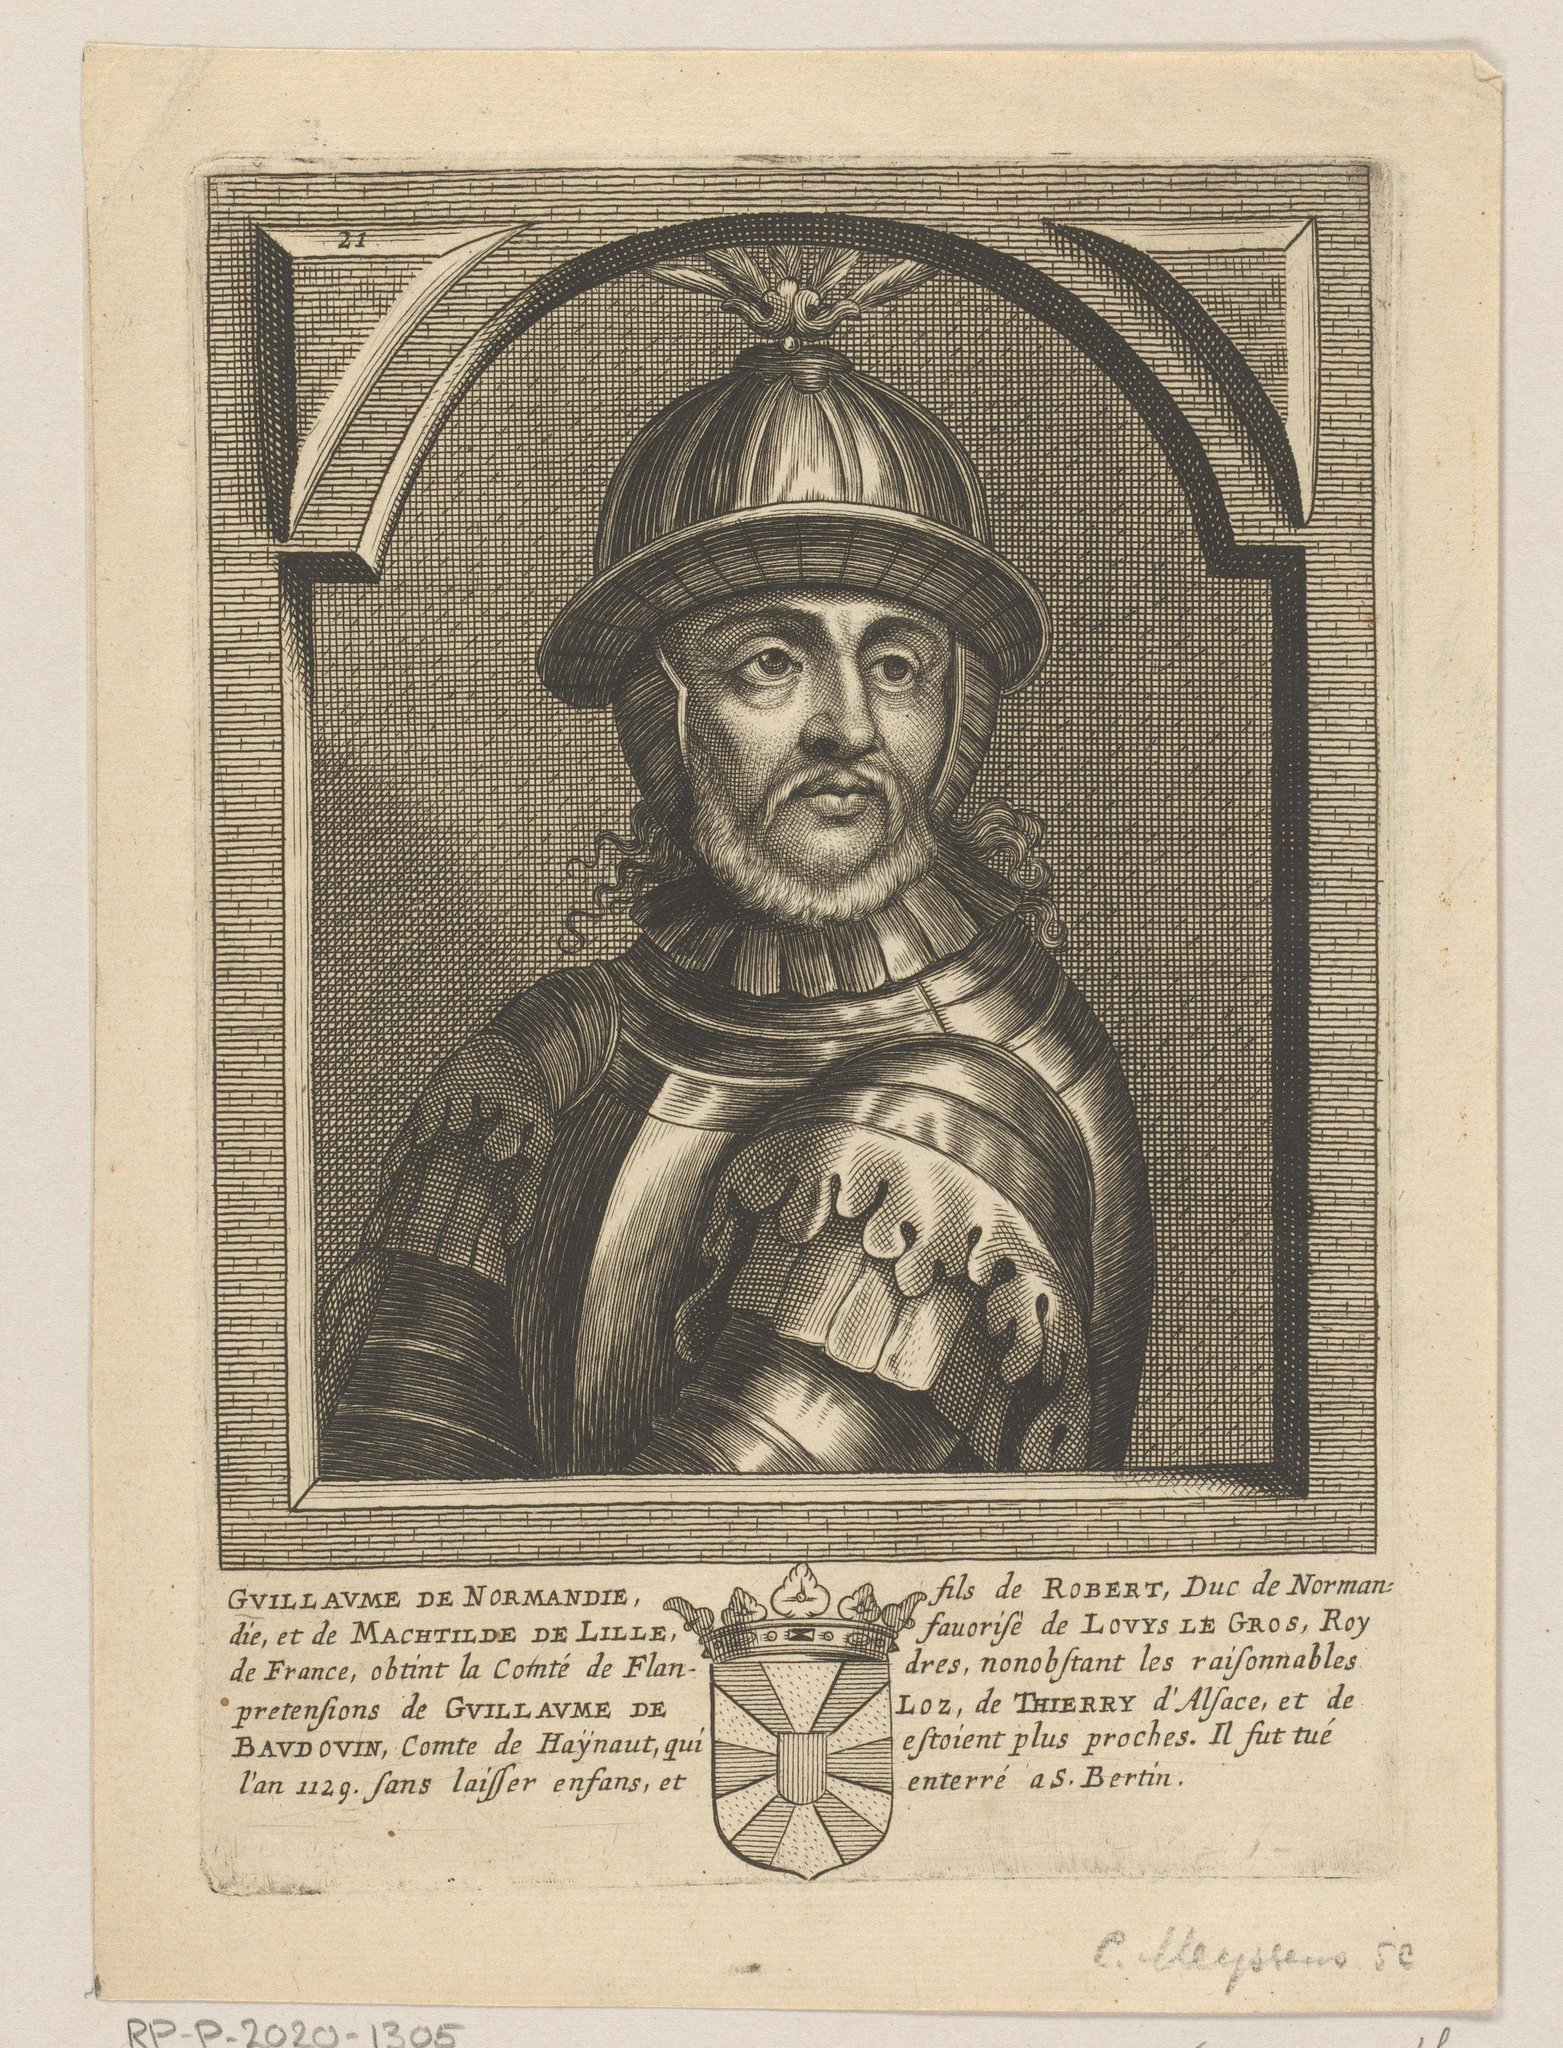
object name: print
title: Portret van Willem Clito, graaf van Vlaanderen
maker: cornelis meyssens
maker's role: print maker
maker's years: 1640-1673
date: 1663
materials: paper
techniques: engraving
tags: earl, historical persons, military clothing and other equipment (uniforms, cap, armour, helmet, etc.)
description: Prent ook gebruikt in: Meyssens, Joannes. Effigies des forestiers et comtes de Flandres. Antwerpen: Joannes Meyssens, 1663.